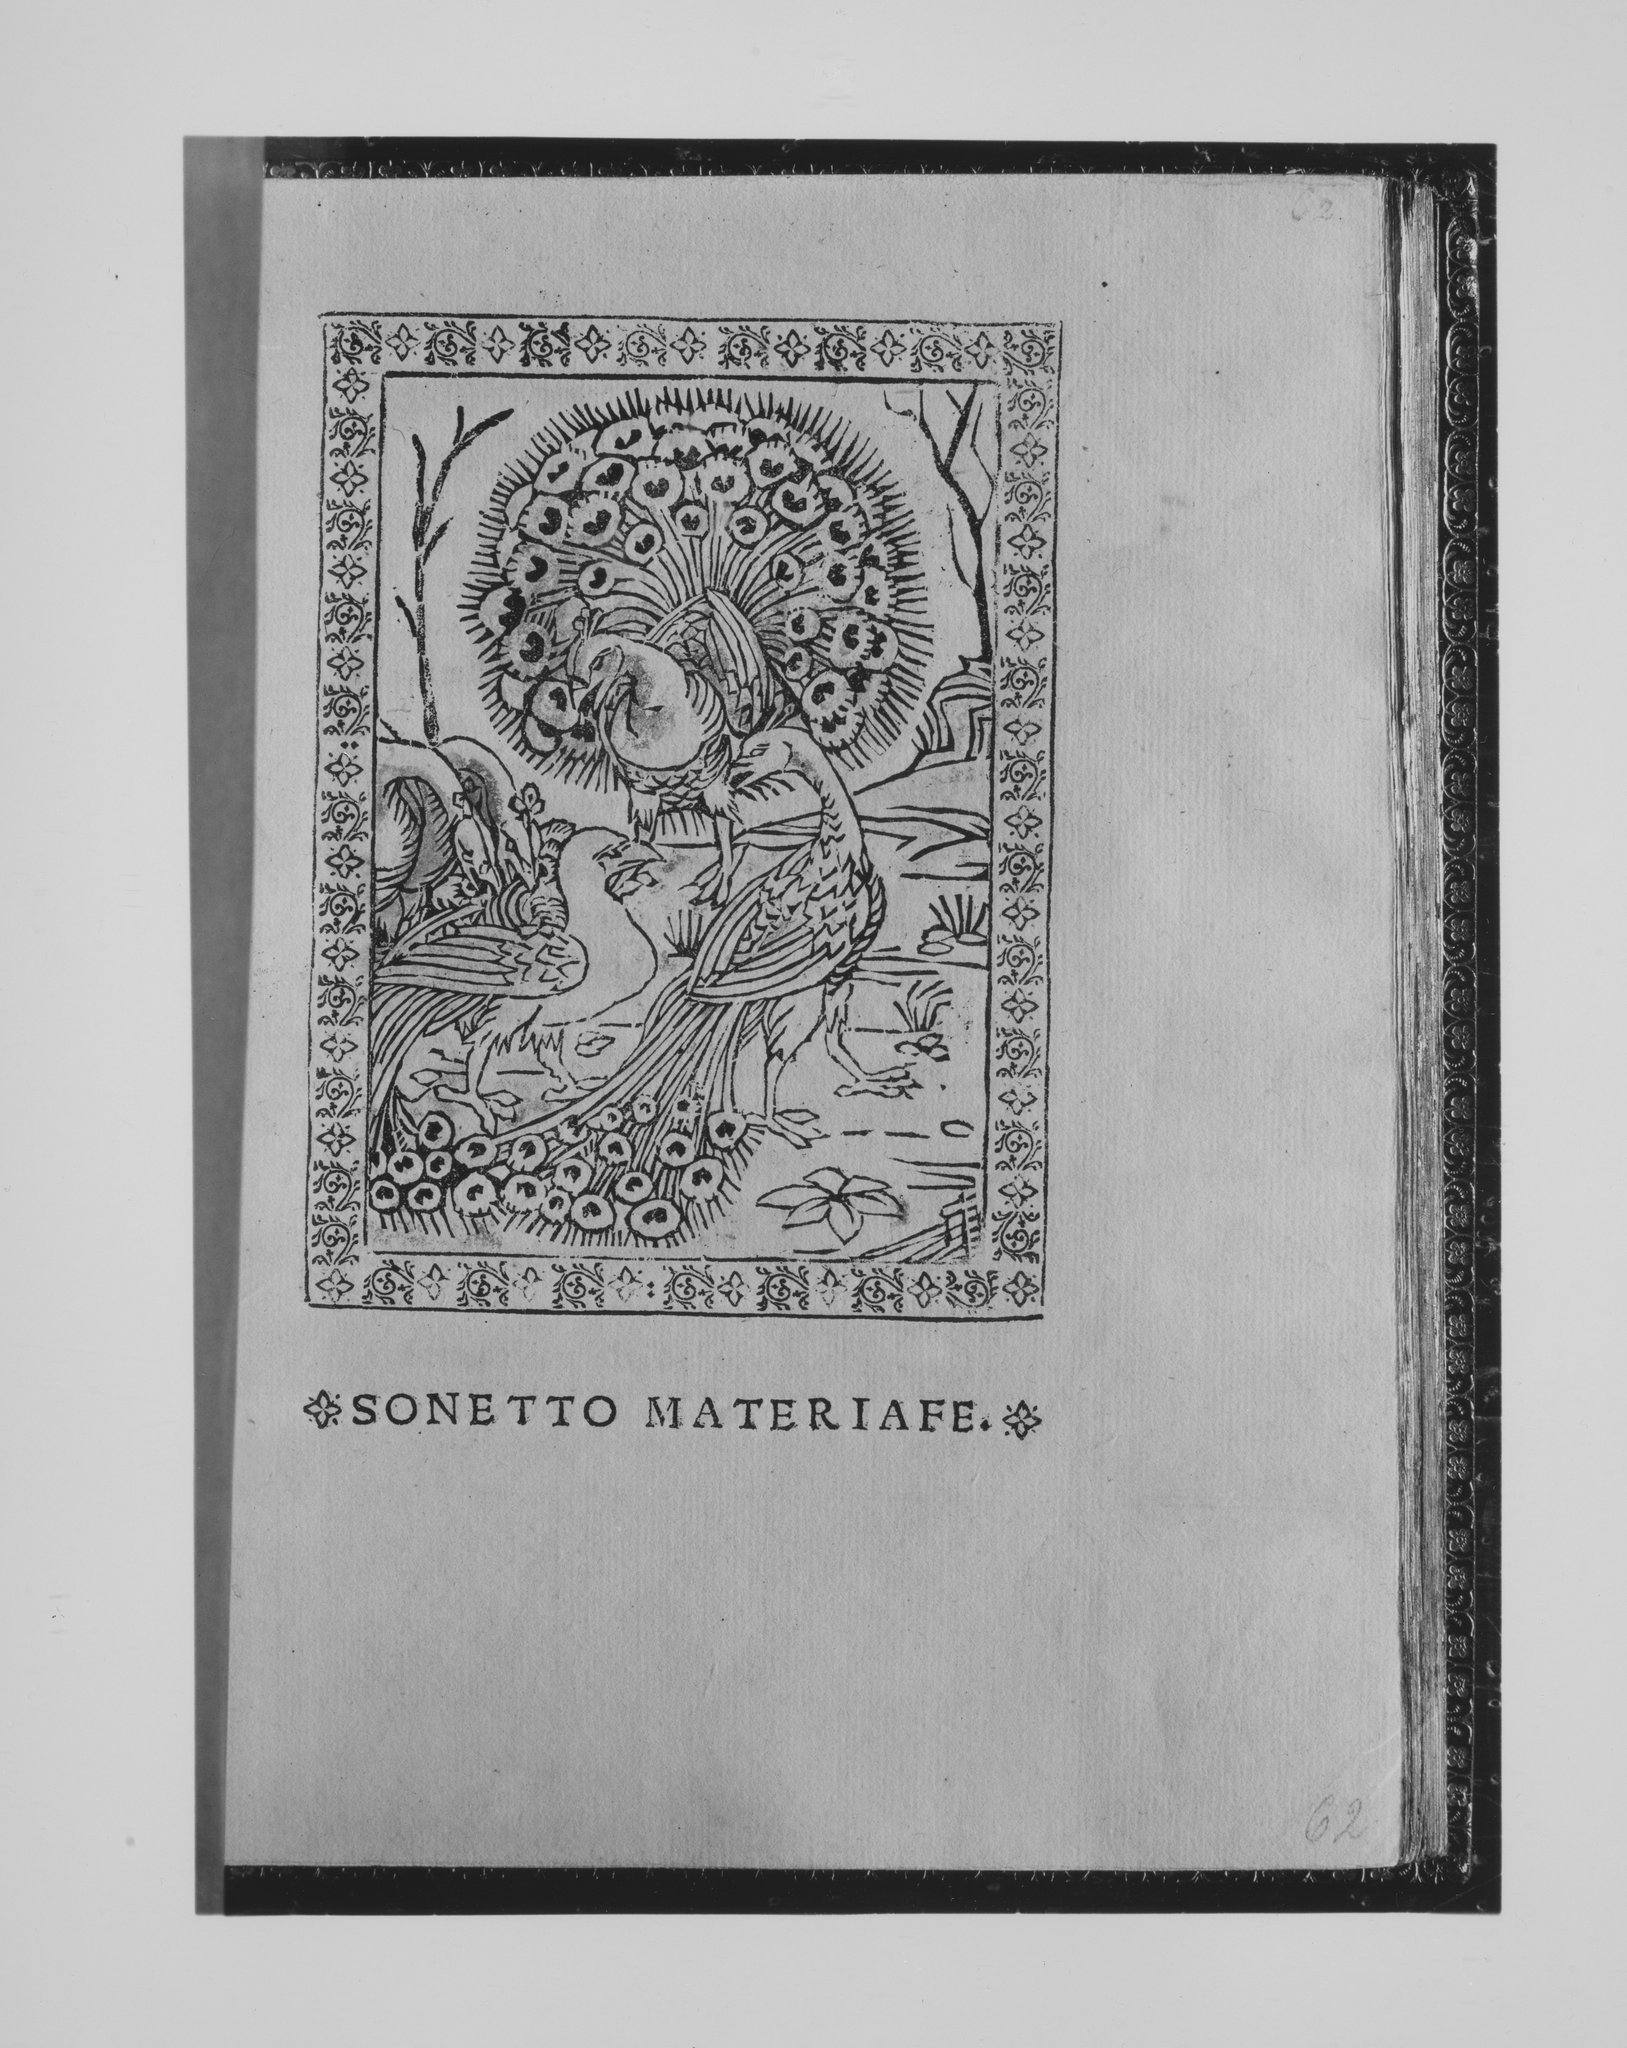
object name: book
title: Aesopi Fabulas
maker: aesop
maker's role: author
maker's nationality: greek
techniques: hand coloring, woodcut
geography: verona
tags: peacocks